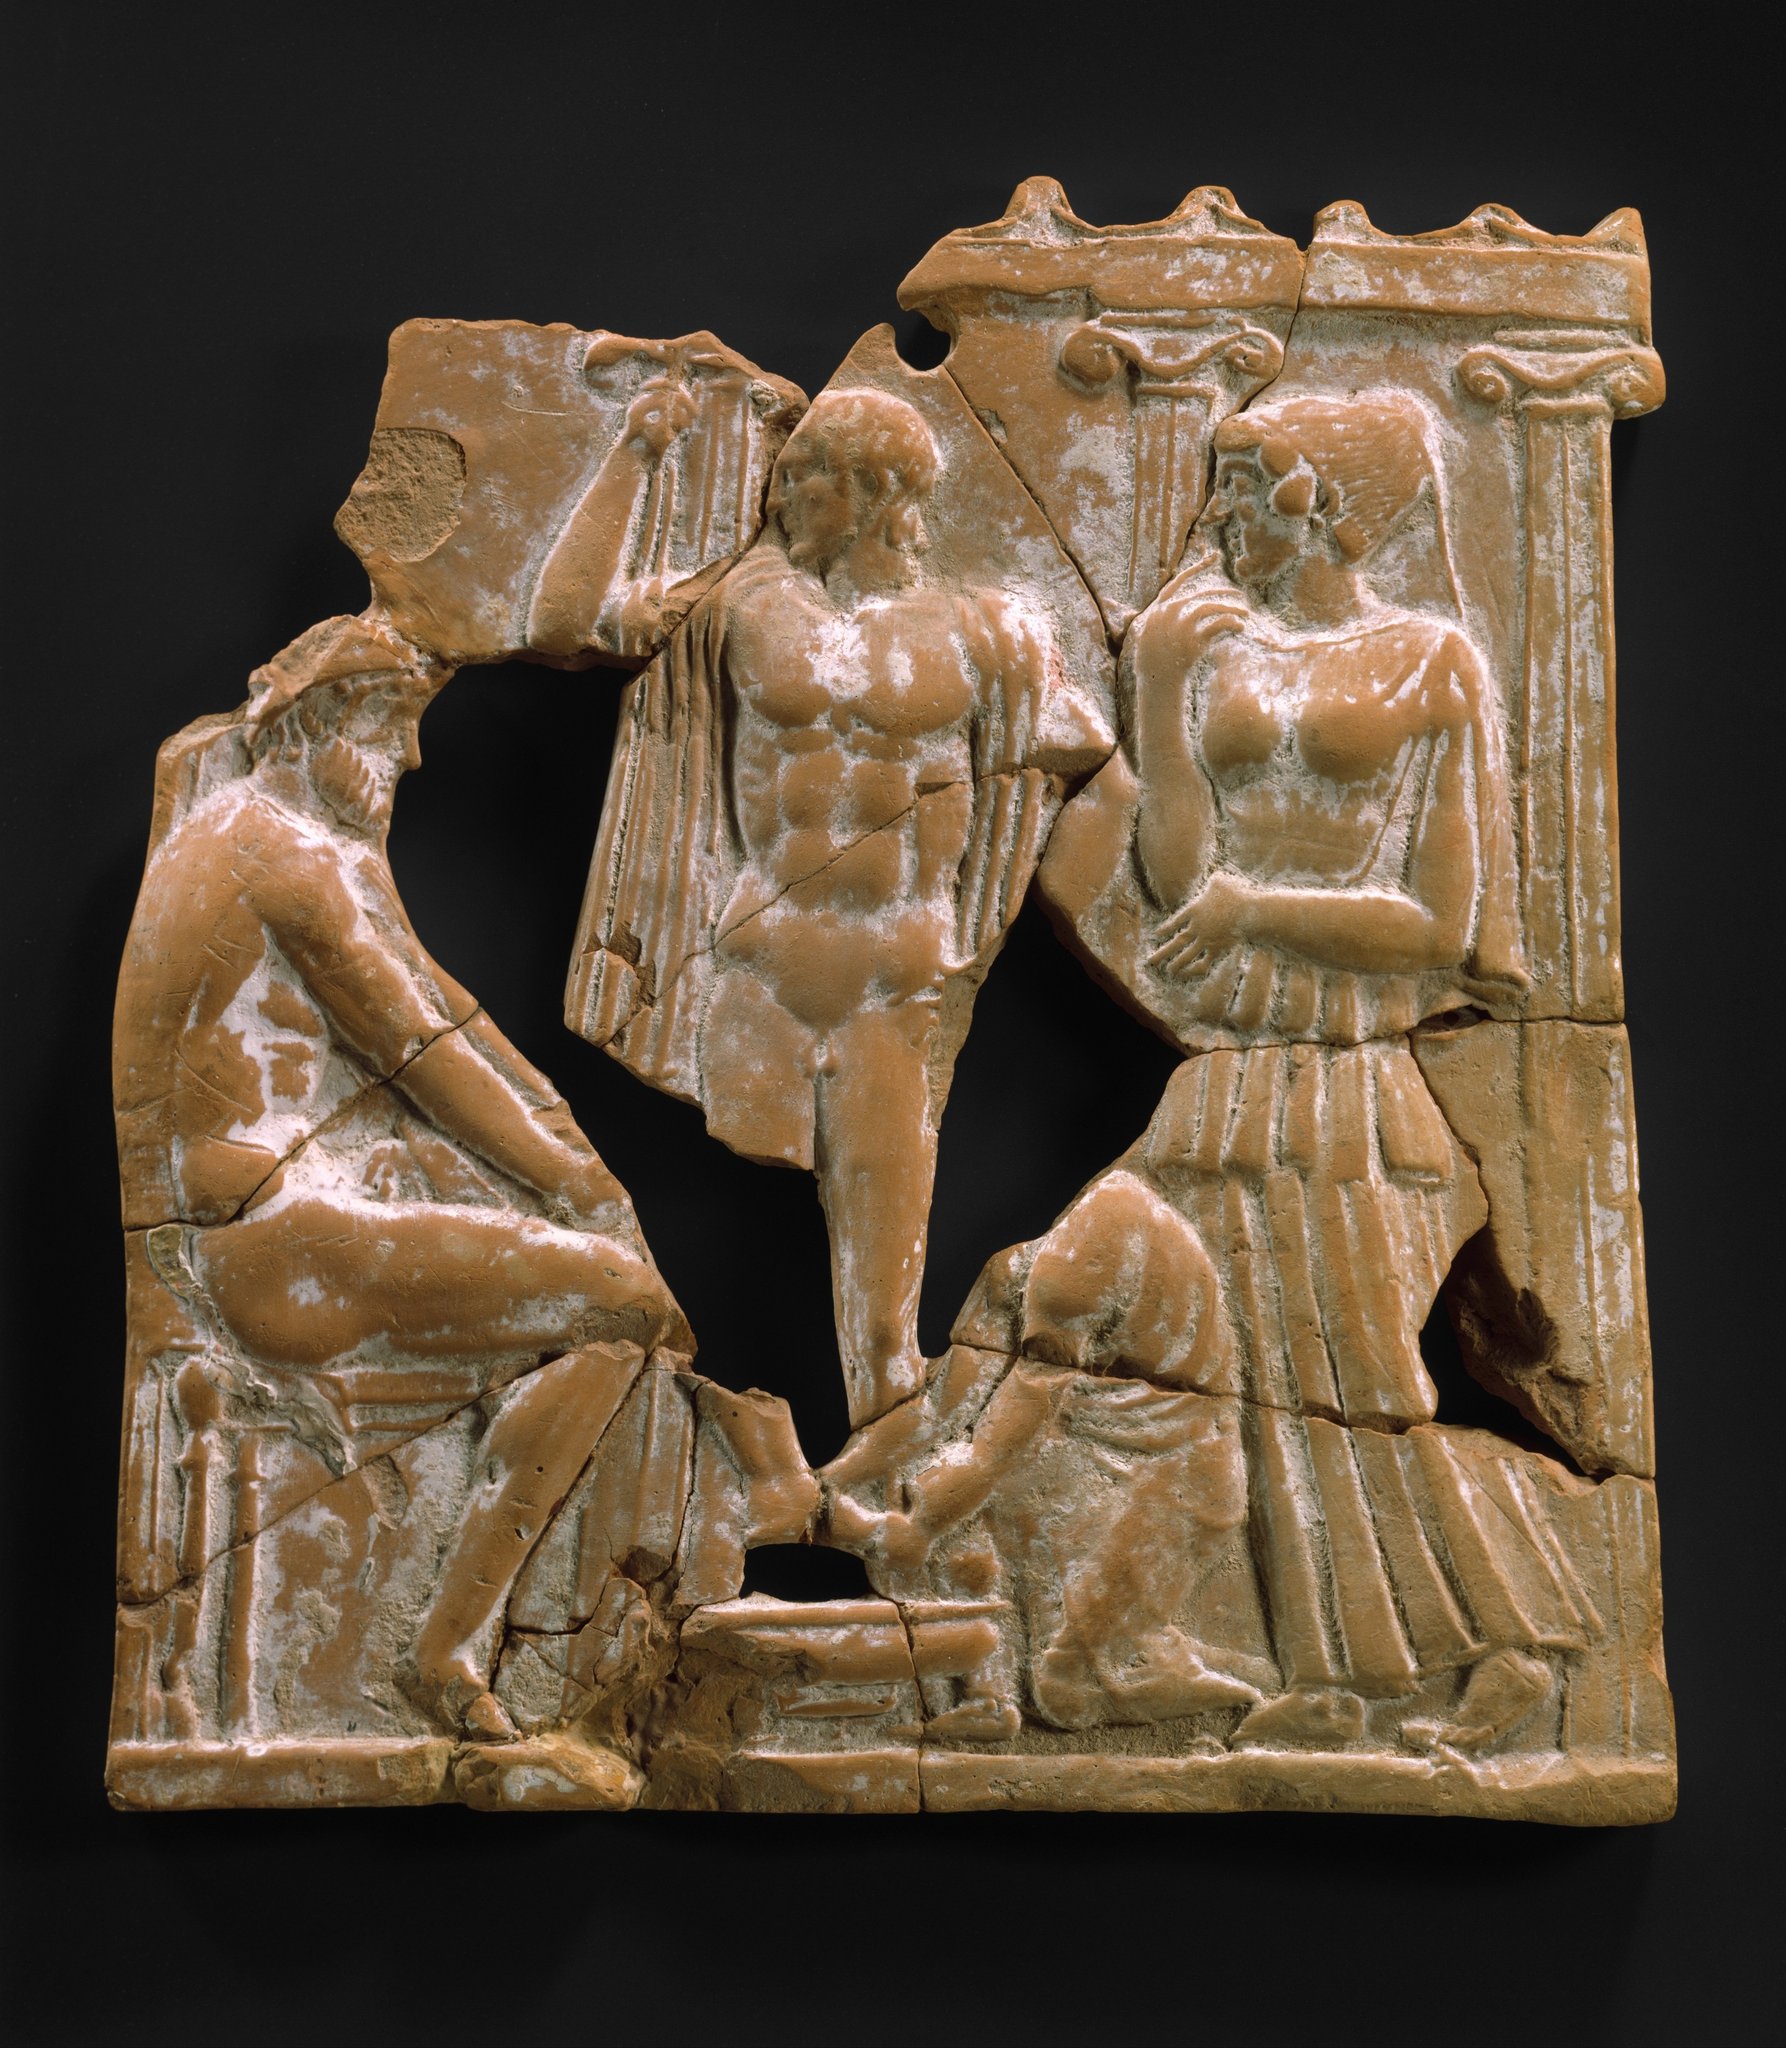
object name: relief of the homecoming of odysseus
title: Terracotta plaque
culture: greek, melian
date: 450 BCE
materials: terracotta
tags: male nudes,women,odysseus